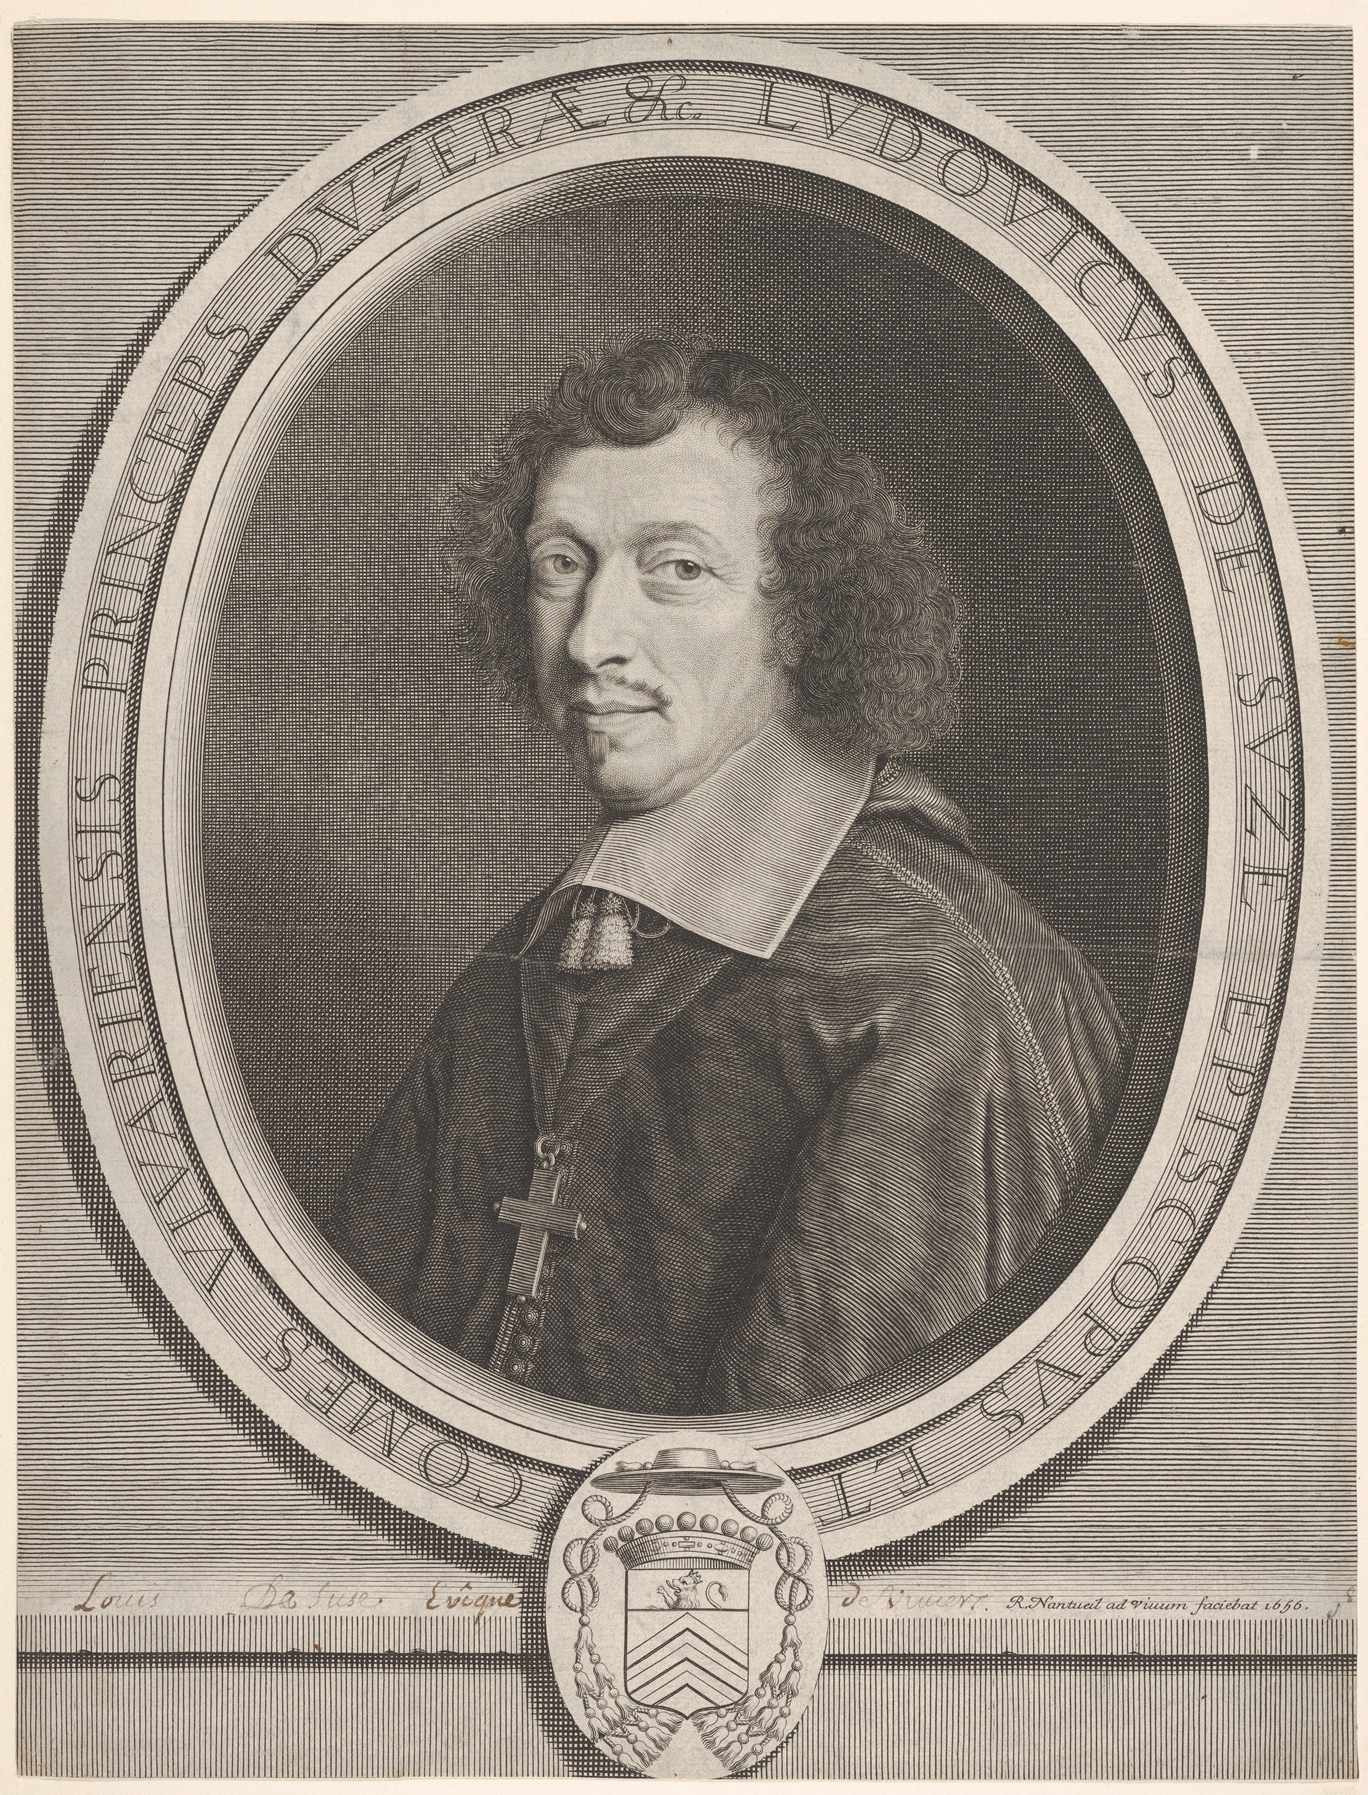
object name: print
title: Louis-François de La Baume de Suze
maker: robert nanteuil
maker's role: artist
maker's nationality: french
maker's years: 1623-1678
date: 1656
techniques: engraving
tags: men,portraits,coat of arms